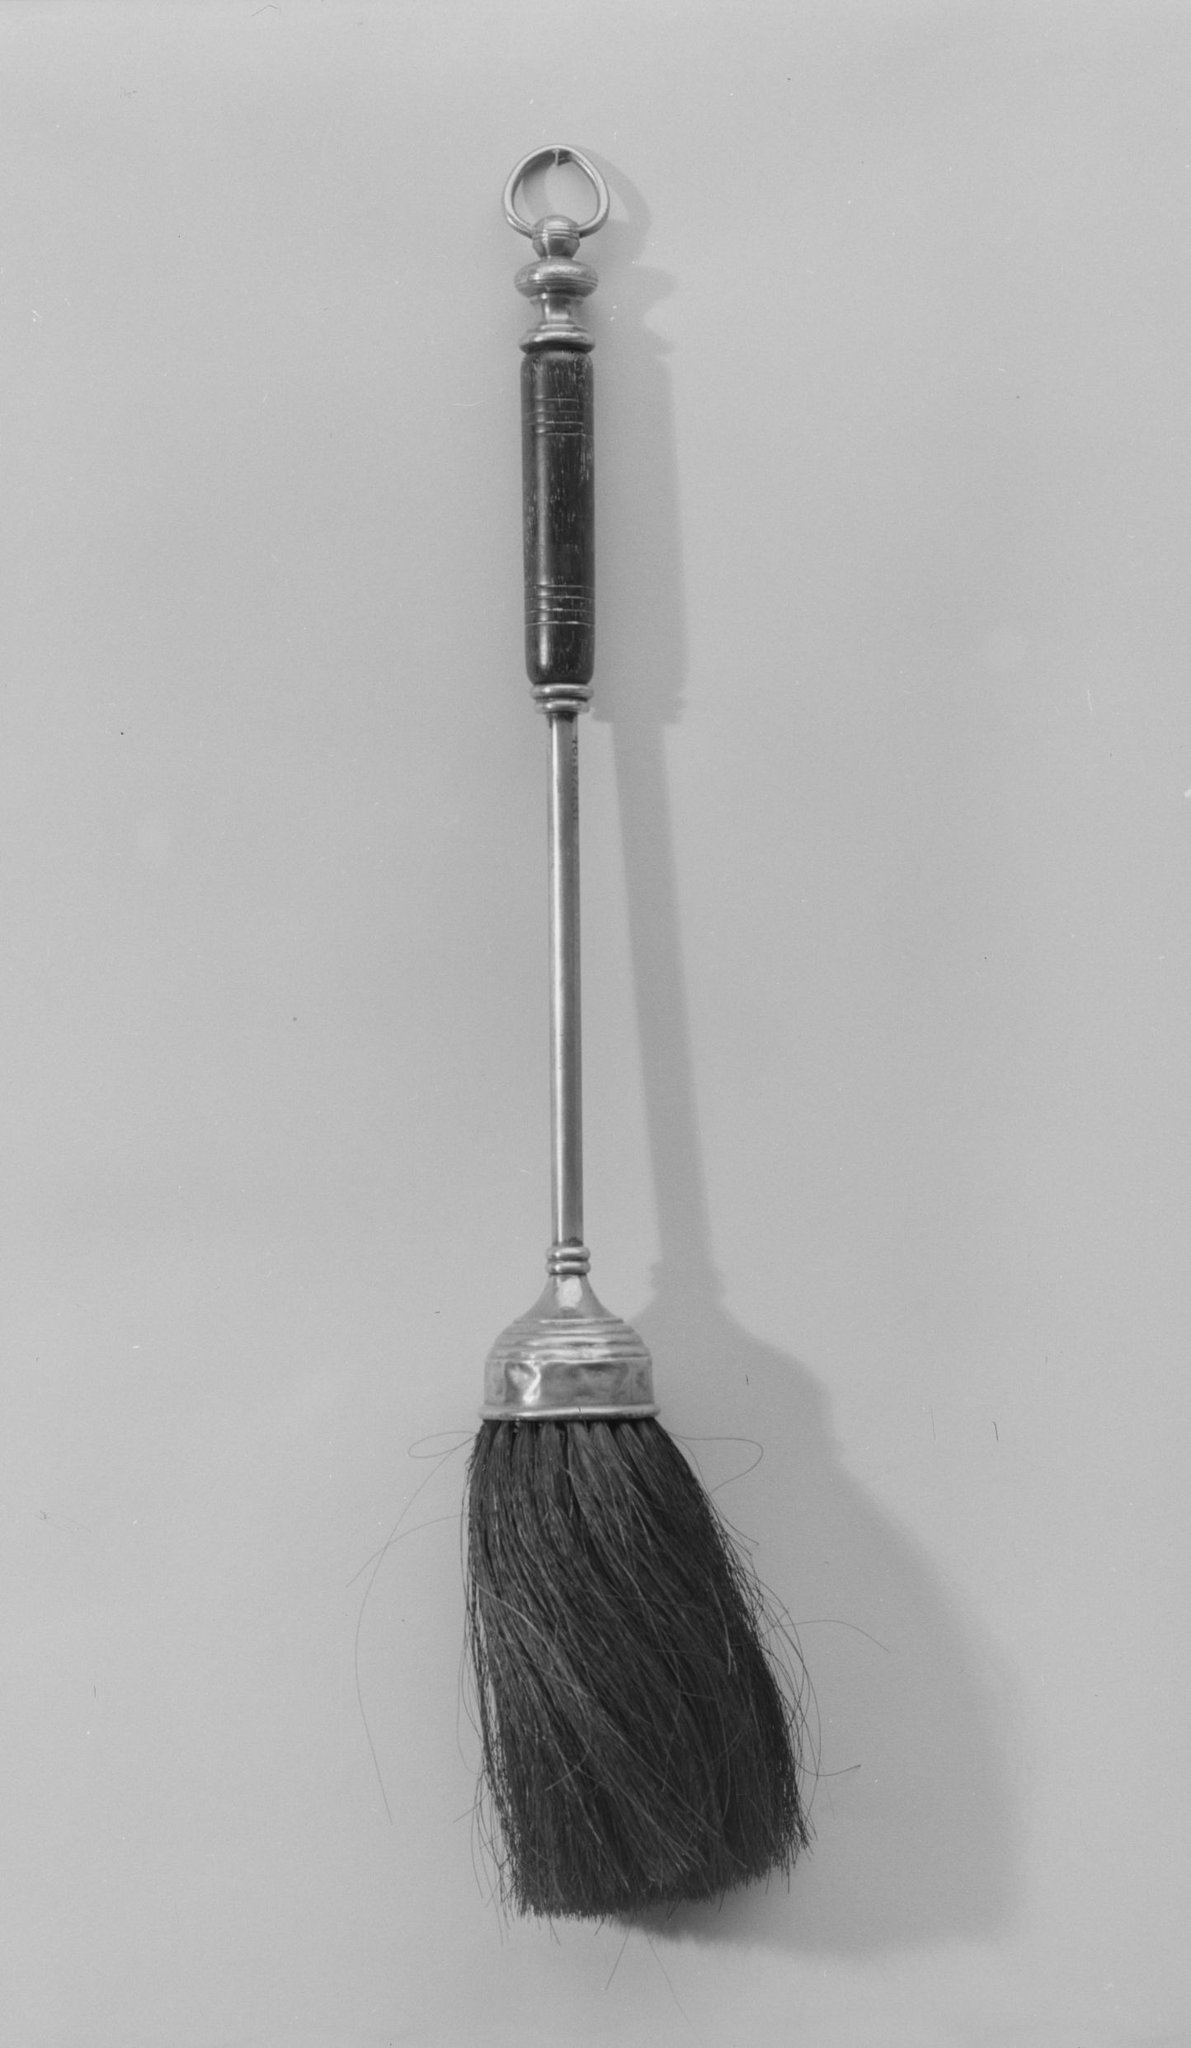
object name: fire brush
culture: american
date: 1795-1815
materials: brass, hair, wood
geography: united states